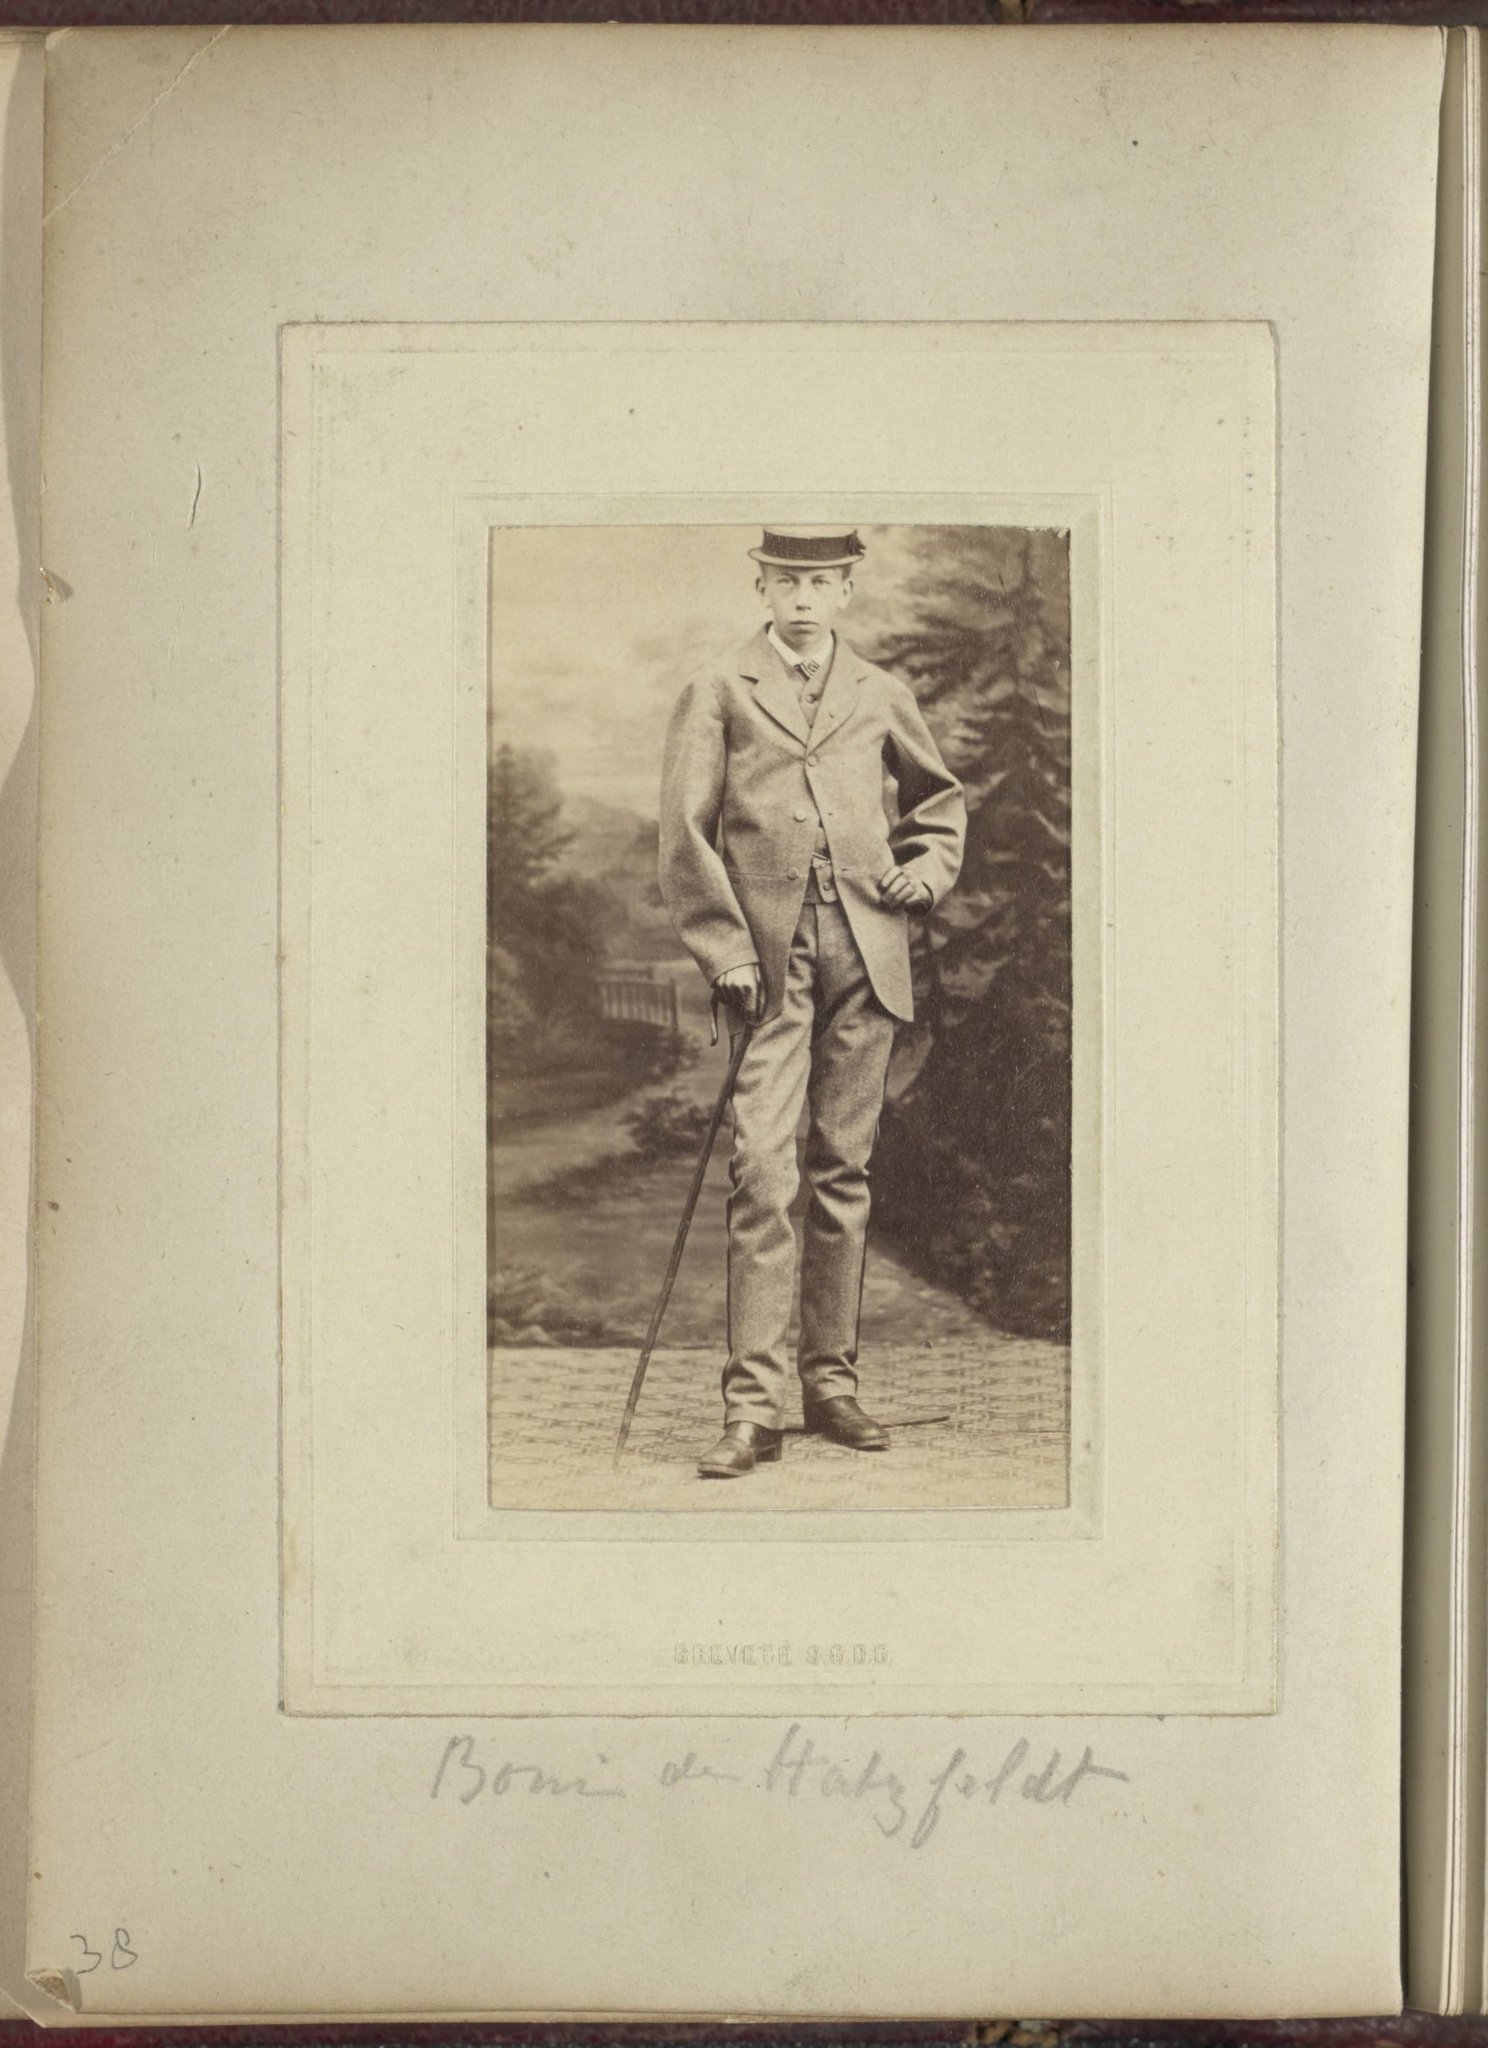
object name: carte de visite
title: Portret van Boni Hatzfeldt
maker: friedrich hundt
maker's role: fotograaf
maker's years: 1807-1887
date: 1809-1868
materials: cardboard, paper, photographic support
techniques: albumen print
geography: munster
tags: studio requisites ~ photographer, trousers, breeches, walking-stick, staff, historical persons, head-gear: hat (+ men's clothes), neck-gear ~ clothing, shoes, sandals, coat, cape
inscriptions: date: ‘septembre 1868’, address: ‘Kreuzstrasse 96 Münster Westfalen’, address: ‘Münster’, inscription: ‘Boni avant Feldther’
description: Onderdeel van Fotoalbum met 48 cartes-de-visite aangeboden aan maarschalk graaf De Castellane.